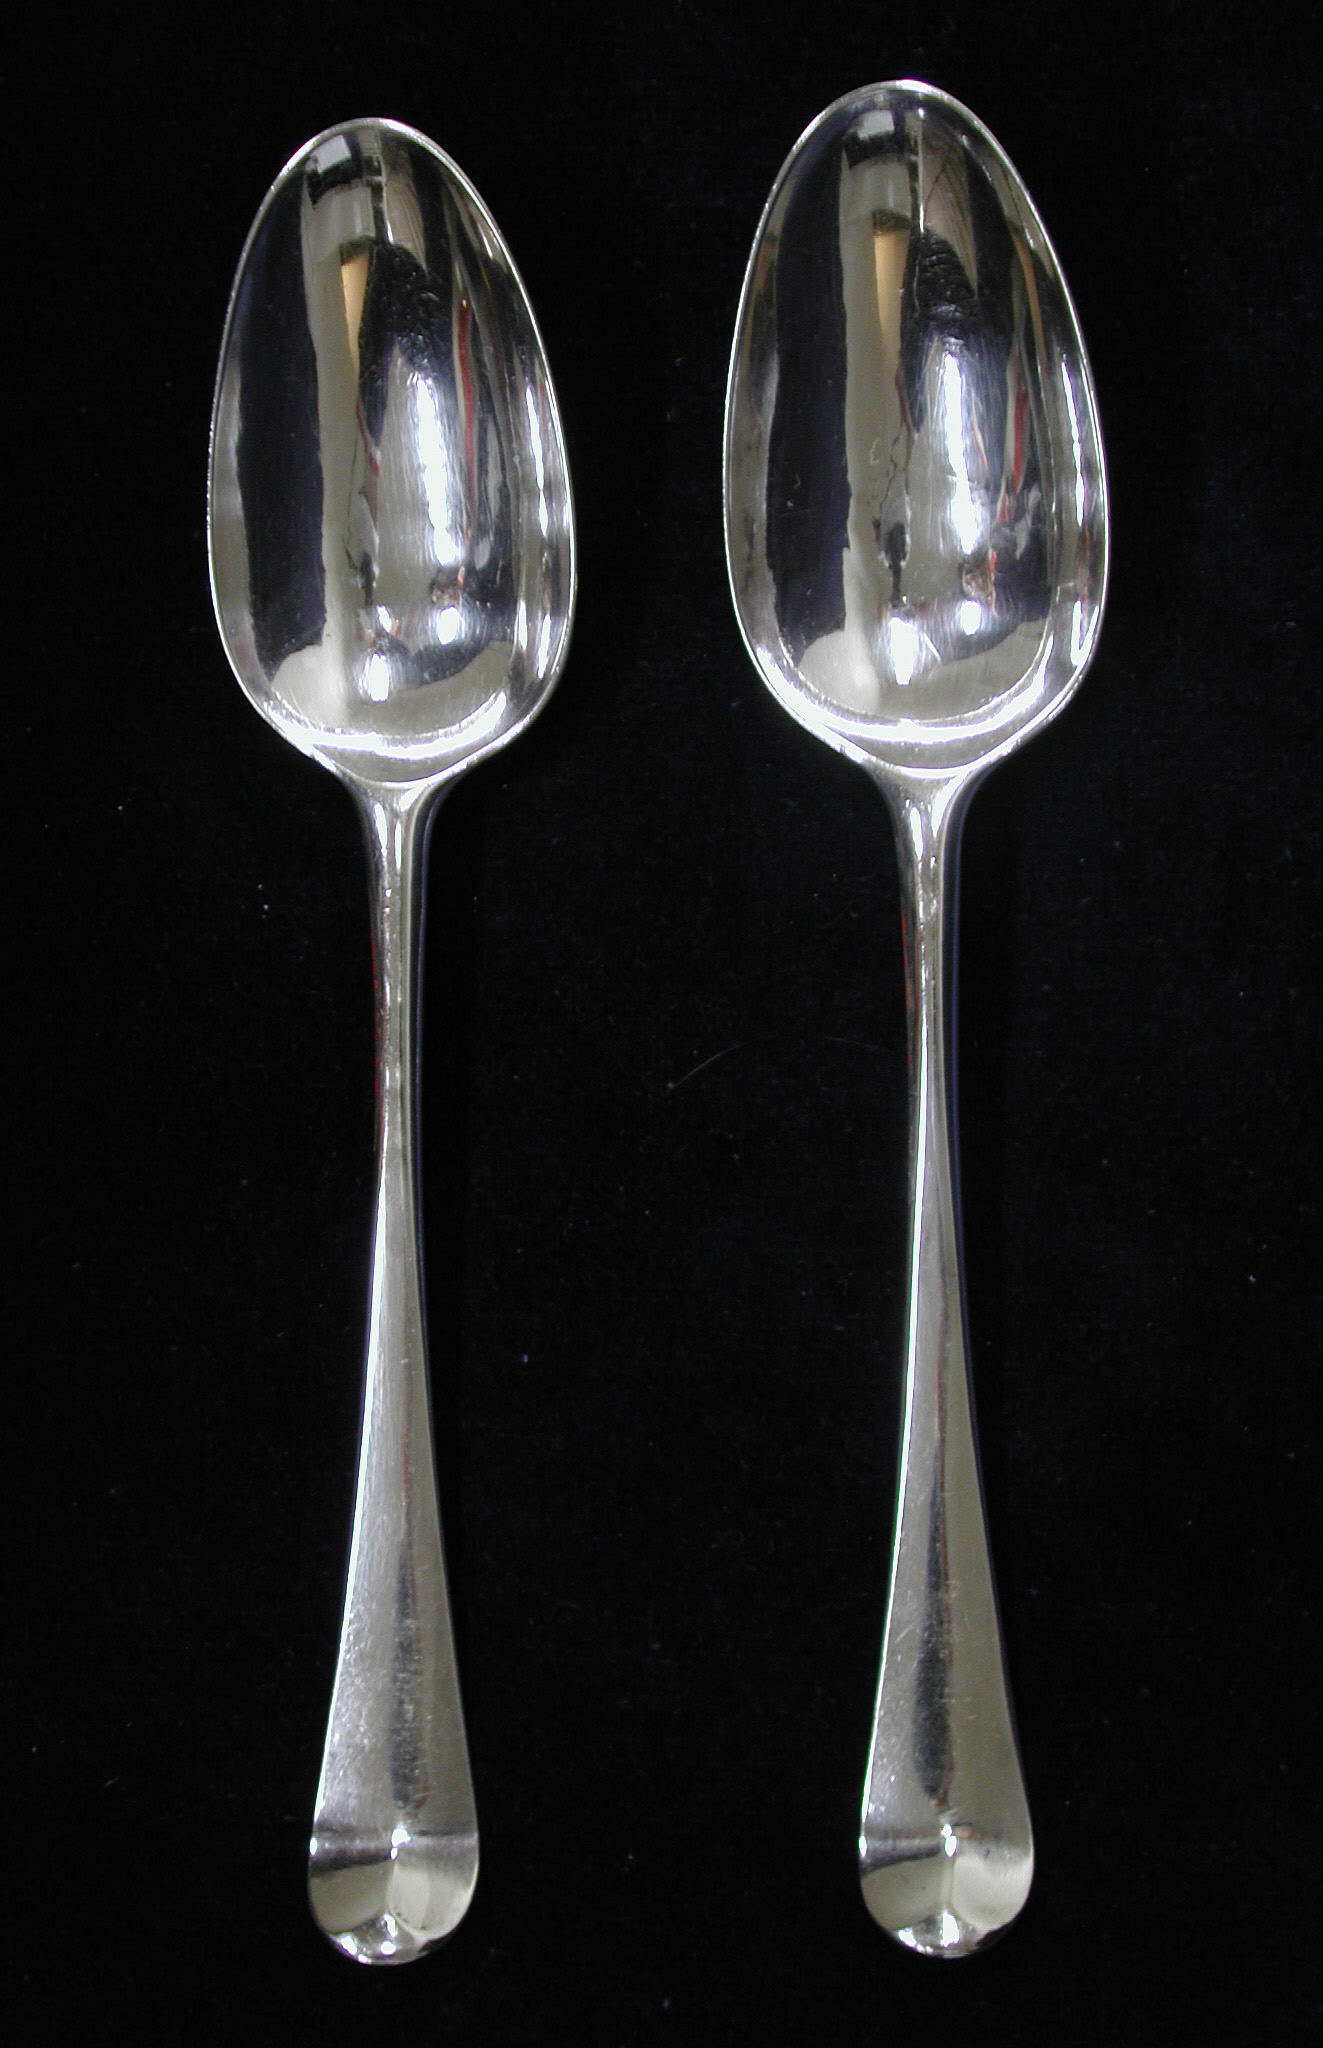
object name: spoon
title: Two spoons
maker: elizabeth tuite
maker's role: maker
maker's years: 1768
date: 1770-1771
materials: silver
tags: lions